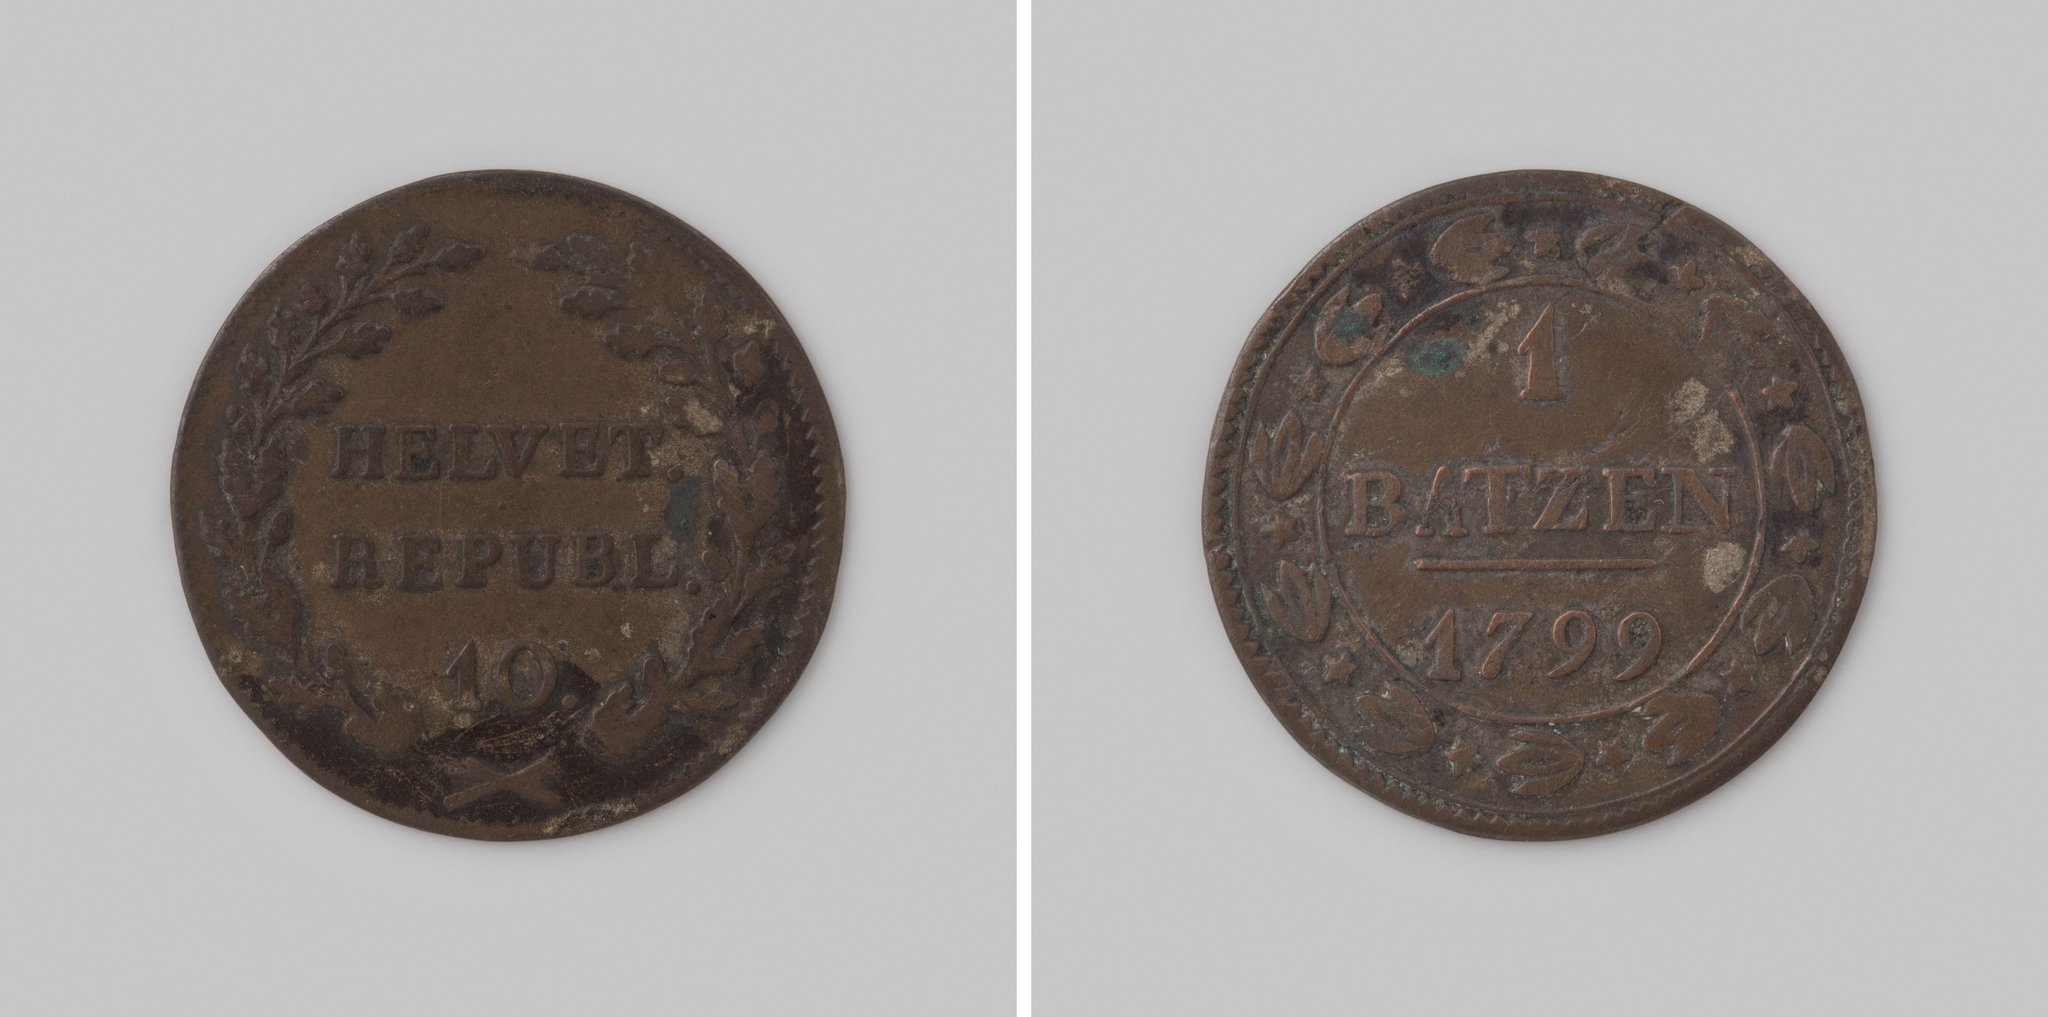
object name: coin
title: Batzen of 10 rappen uit de Helvetische Republiek, 1799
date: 1799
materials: copper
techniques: striking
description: Koperen munt. Voorzijde: tussen twee takken in twee regels lands-aanduiding, waaronder waarde-aanduiding: 10. Keerzijde: binnen krans in twee regels waarde-aanduiding: 1 batzen, waaronder jaartal. Gladde rand.